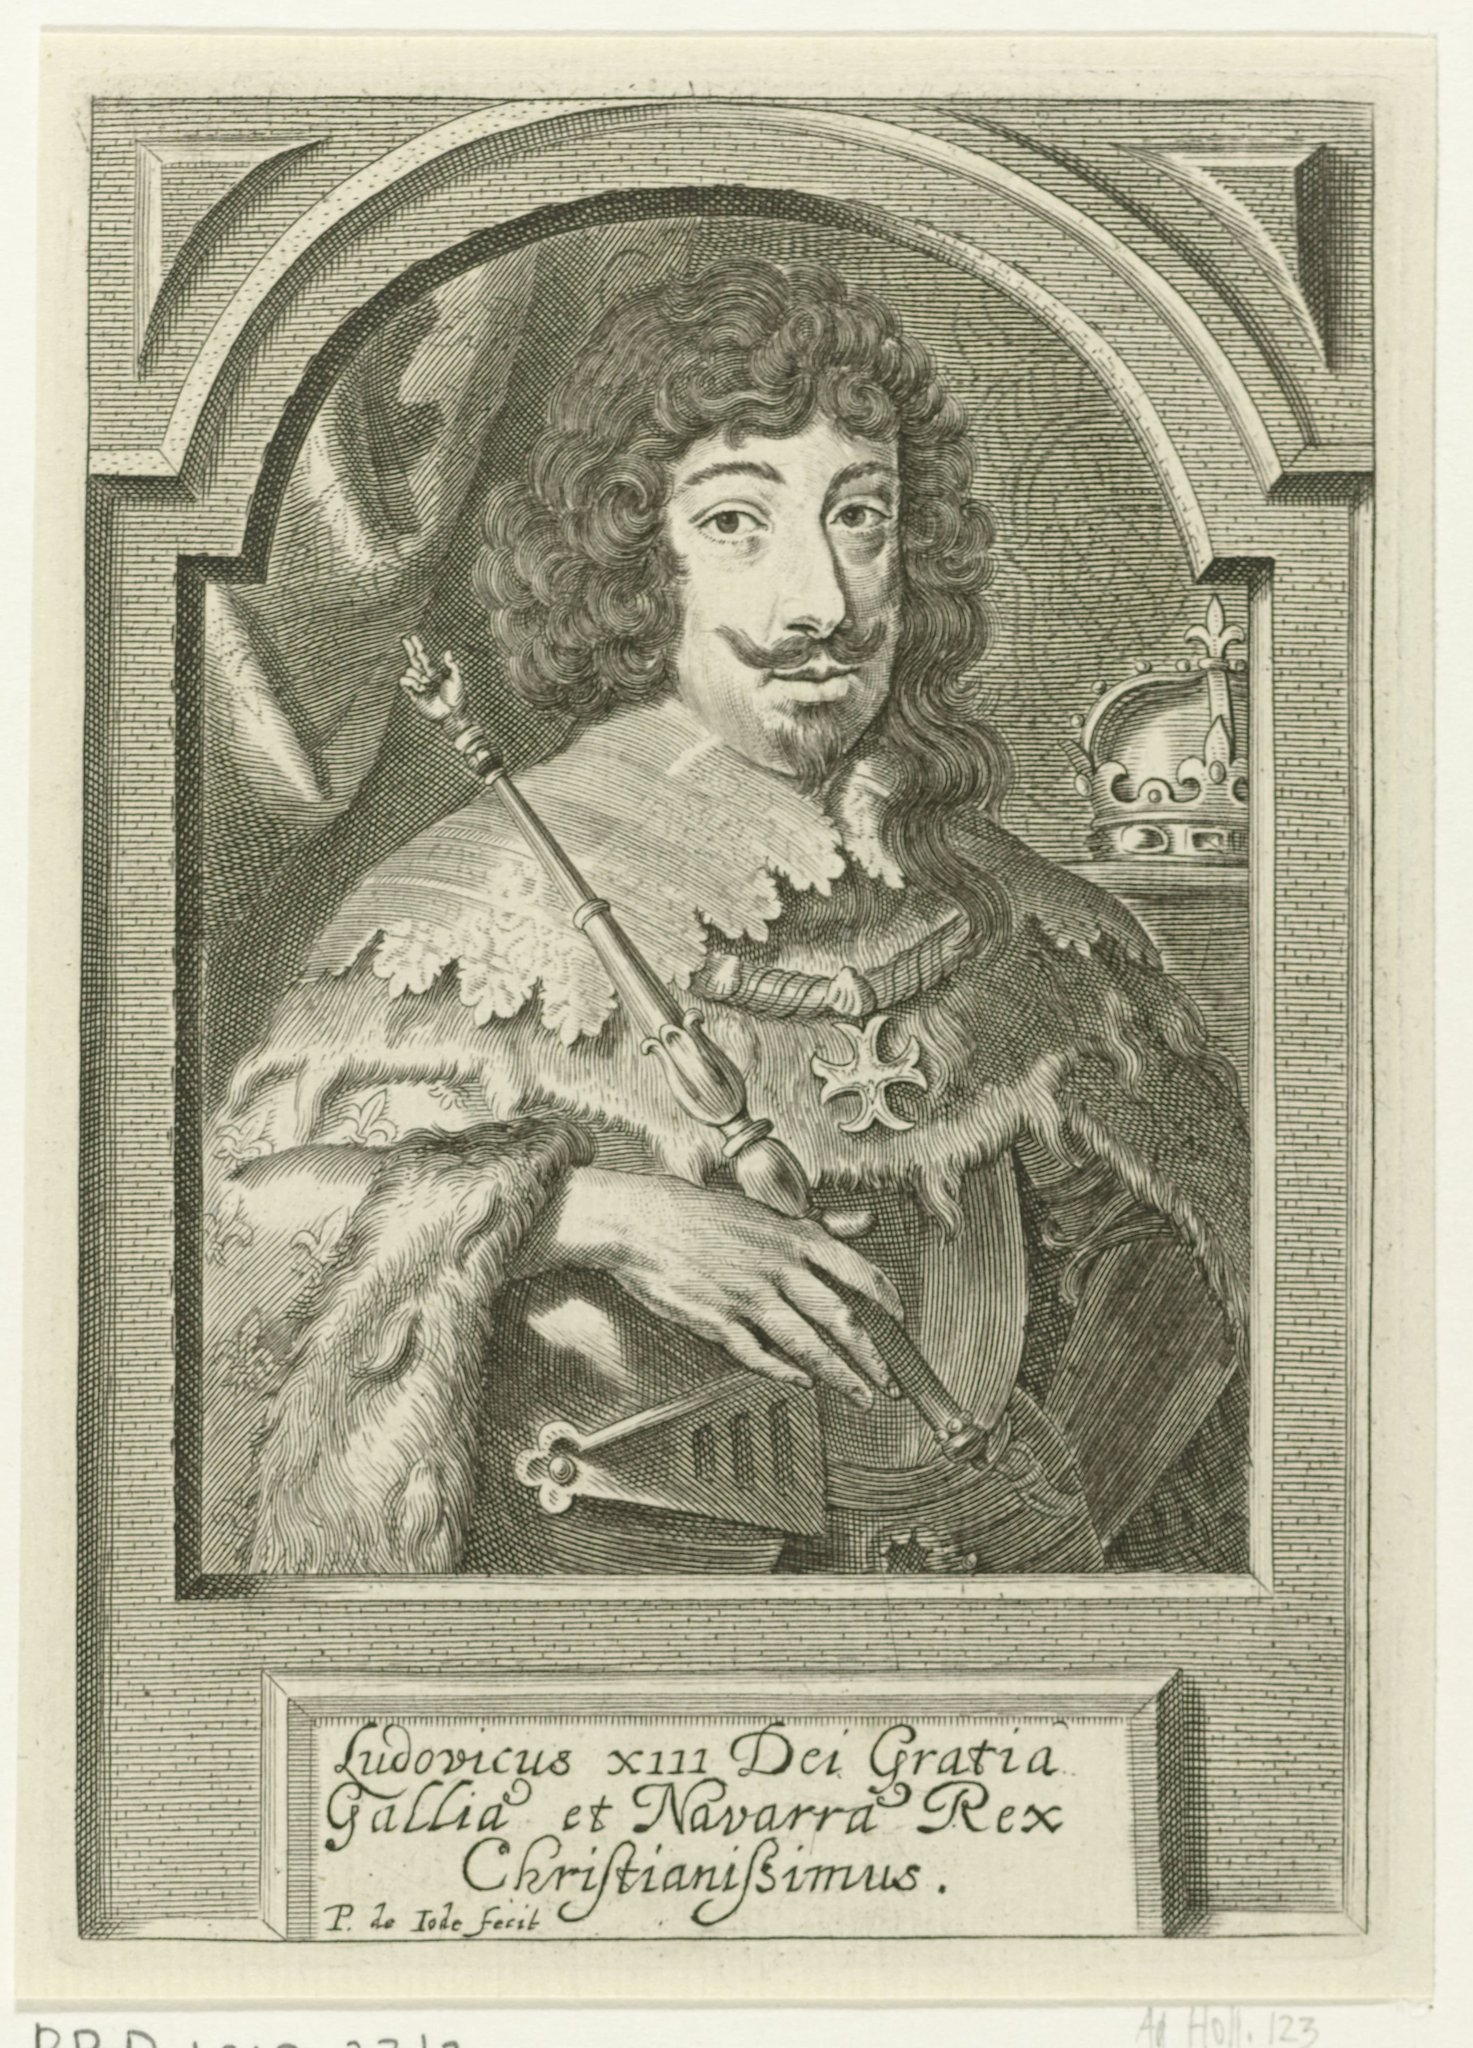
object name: print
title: Theater van bisschoppen, keizers, koningen, hertogen, prinsen, enz.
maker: pieter de jode (ii)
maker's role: draughtsman, print maker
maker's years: 1606-1674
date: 1628-1670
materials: paper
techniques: engraving, etching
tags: lodewijk xiii (koning van frankrijk), crown (symbol of sovereignty)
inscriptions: collector's mark: Lugt 2228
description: Portret van Lodewijk XIII, koning van Frankrijk. In zijn rechterhand houdt hij een staf. Op de achtergrond een kroon. Het portret is gevat in een boogvormige omlijsting. In een kader een drieregelig onderschrift in het Latijn.